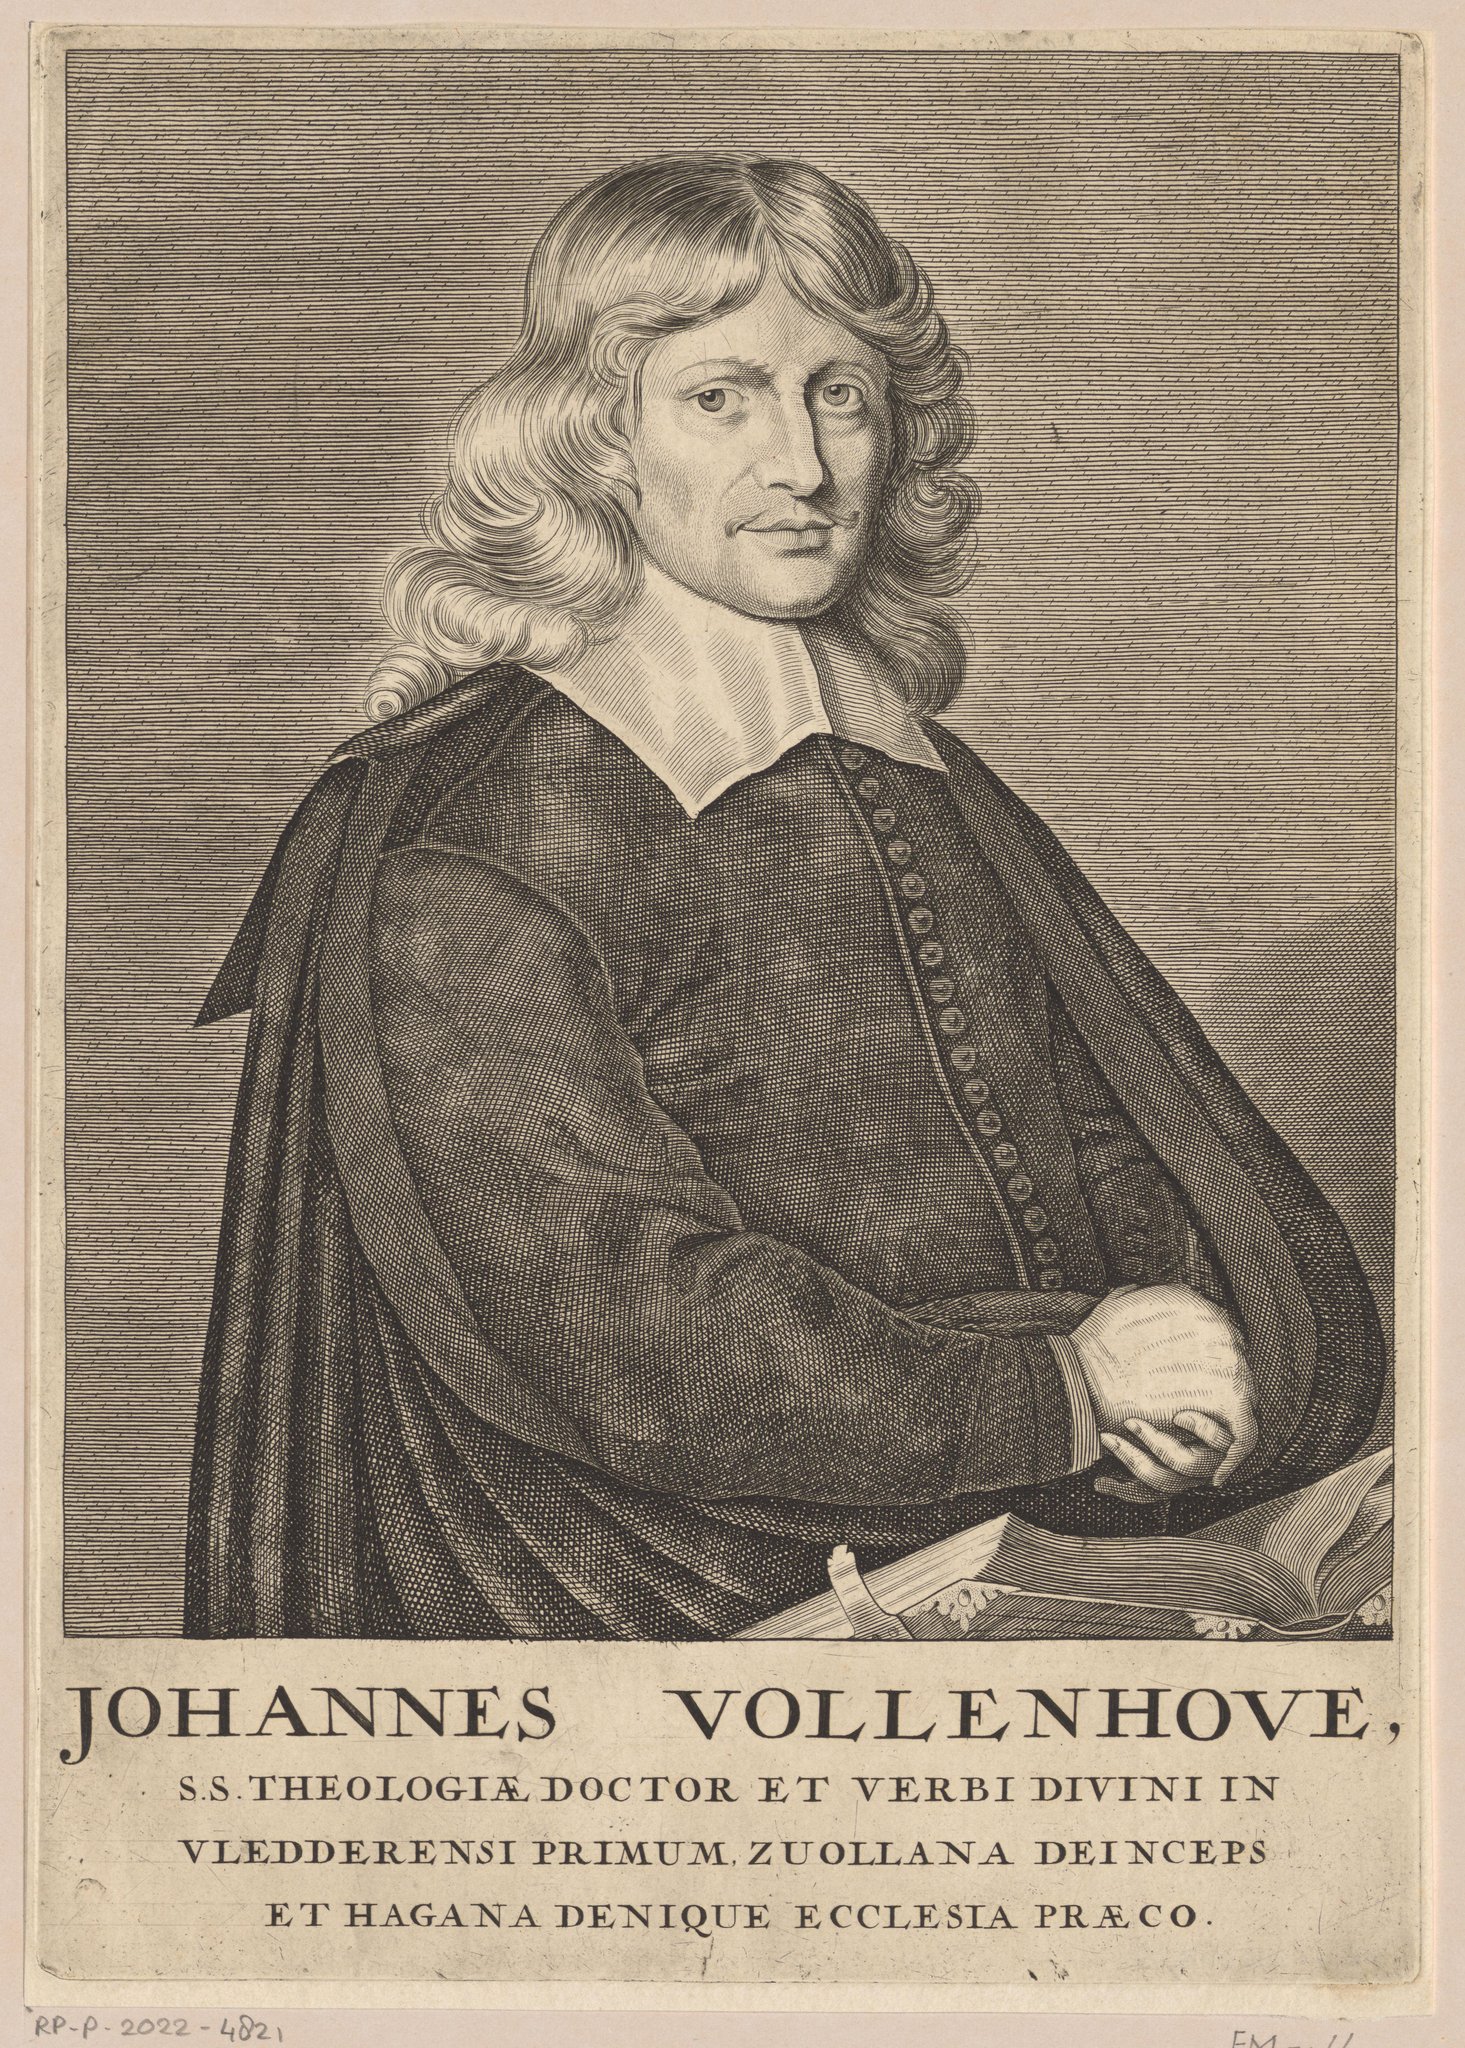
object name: print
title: Portret van Joannes Vollenhove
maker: Anonymous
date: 1660-1700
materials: paper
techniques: engraving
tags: theologian, historical persons, writer, poet, author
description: Met drieregelig onderschrift in het Latijn.